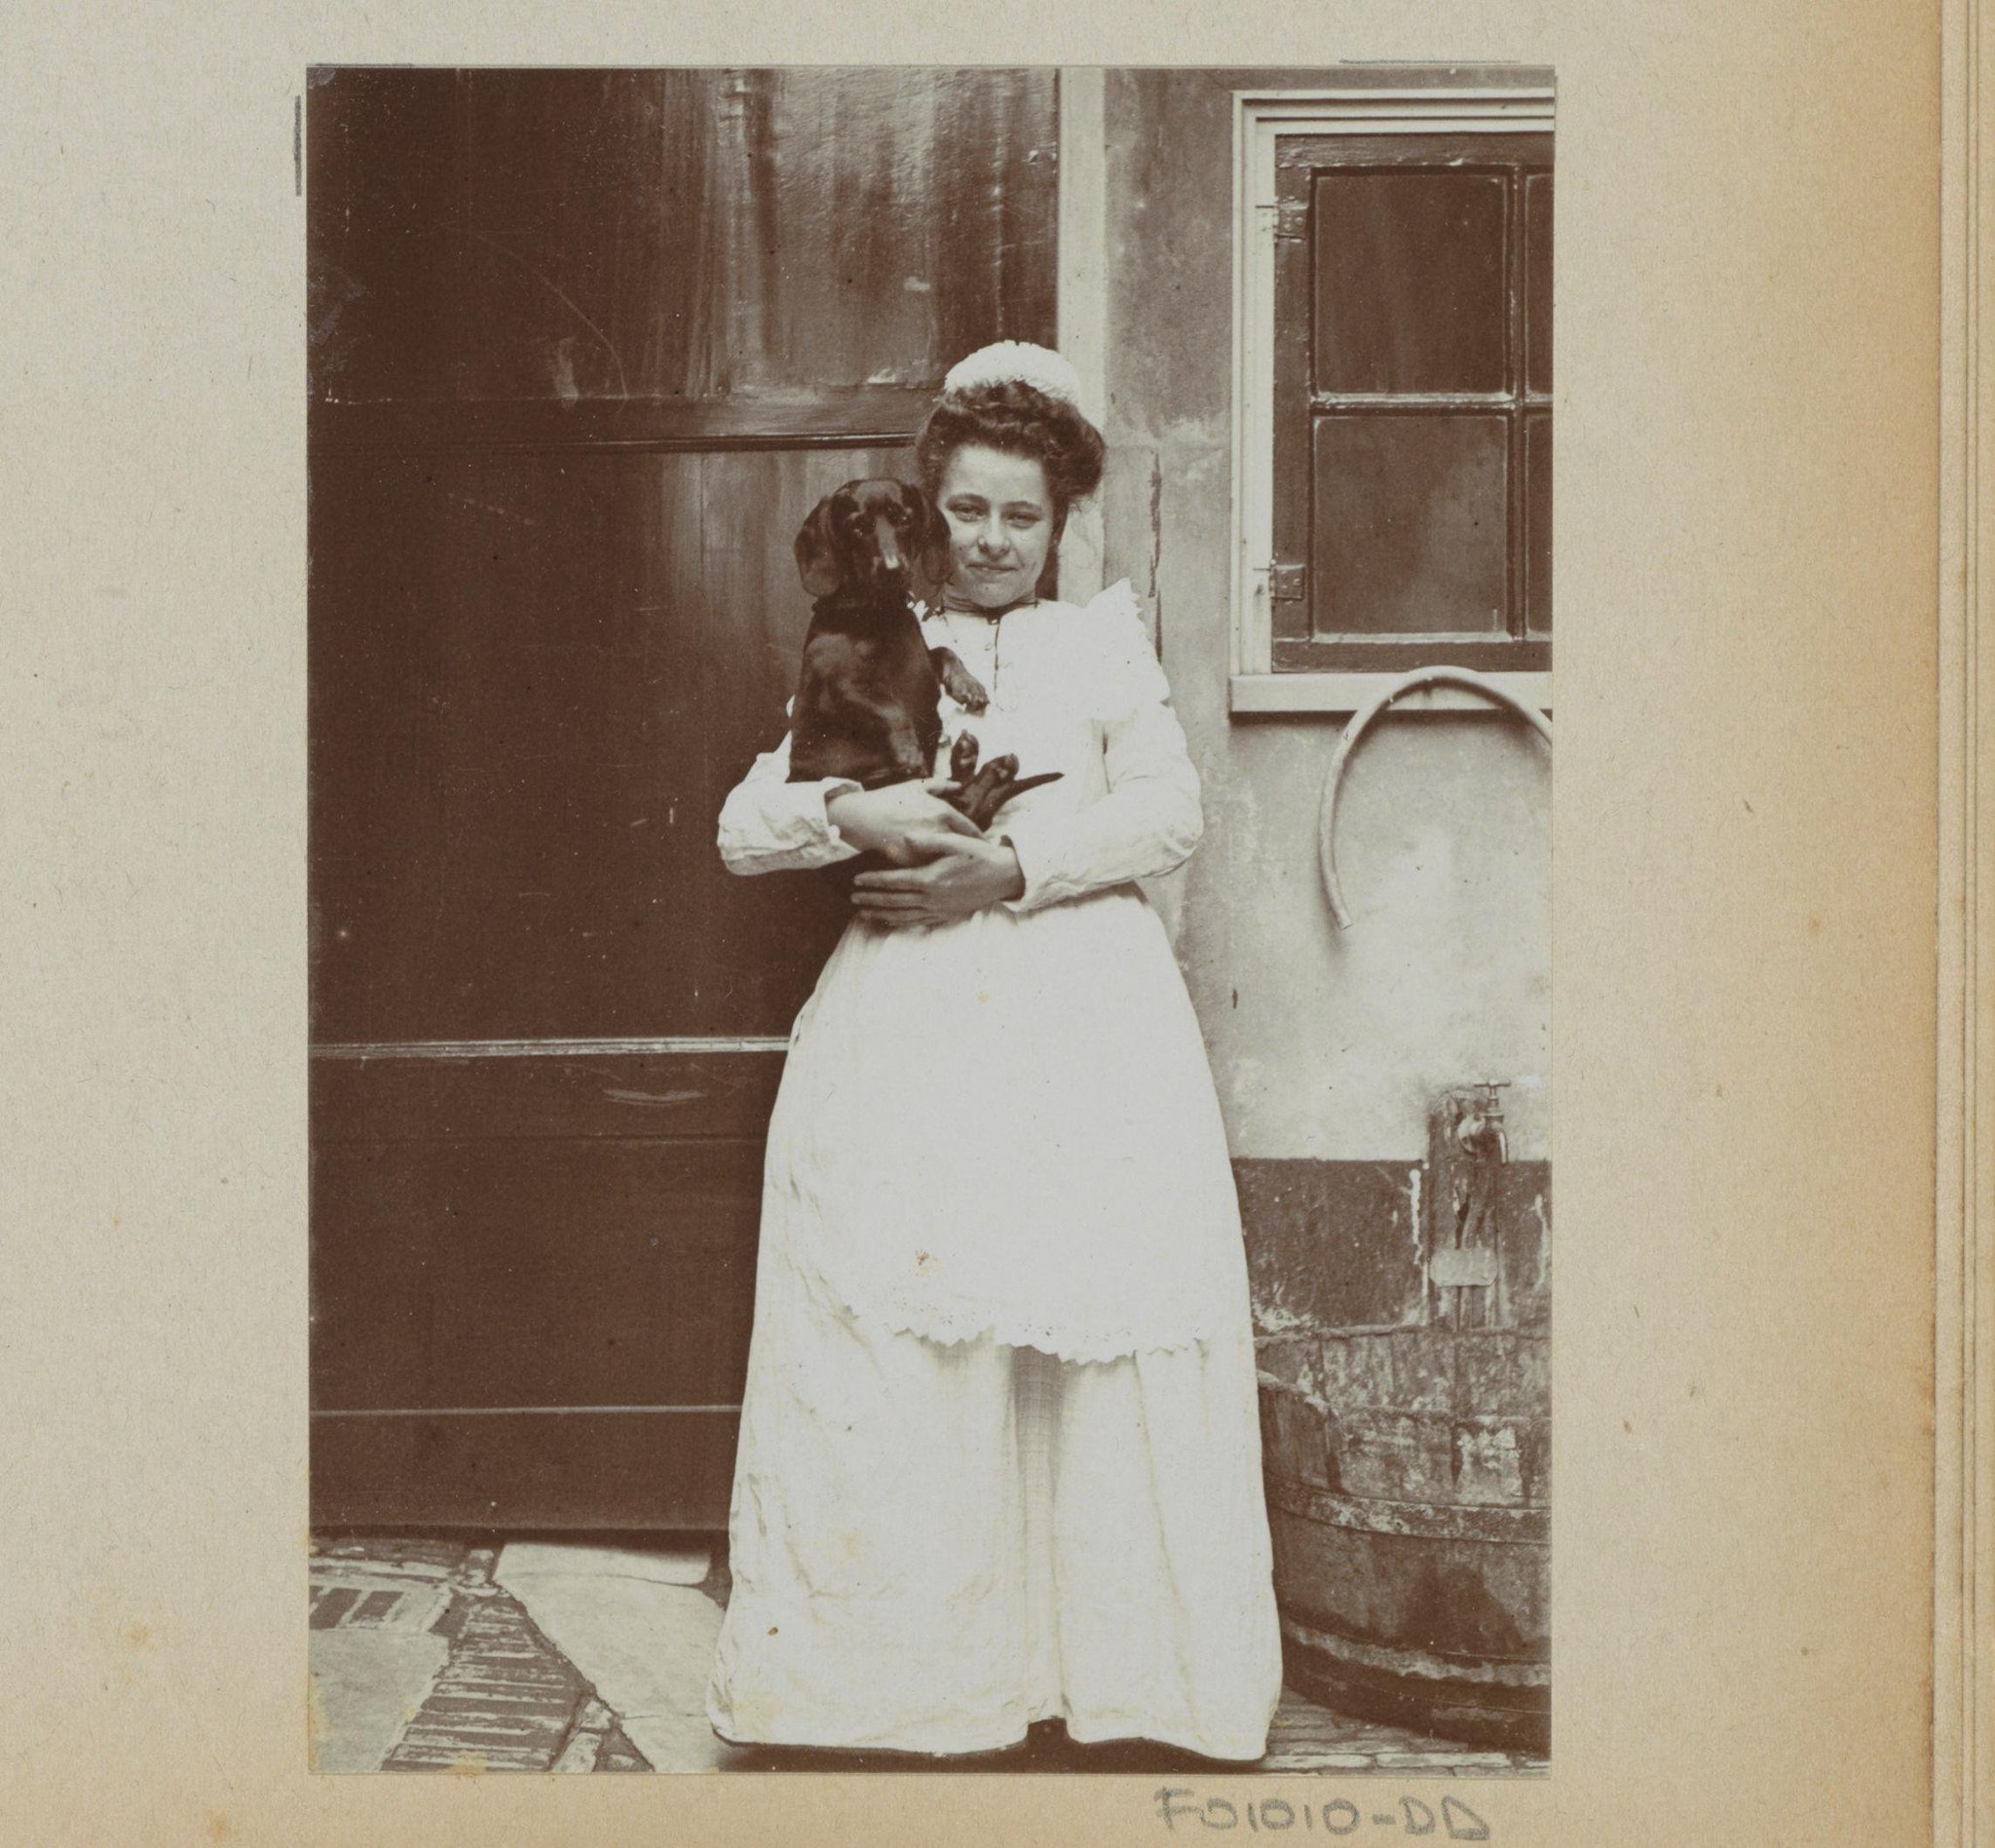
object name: photograph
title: Dienstbode met een takshond in de armen bij een buitenkraan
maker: Anonymous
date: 1900-1910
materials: photographic support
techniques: gelatin silver print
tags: kitchen-maid, kitchen servant, dog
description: Onderdeel van Familiealbum met onder meer foto's van Wijnhandel Kraaij & Co. Bordeaux-Amsterdam.